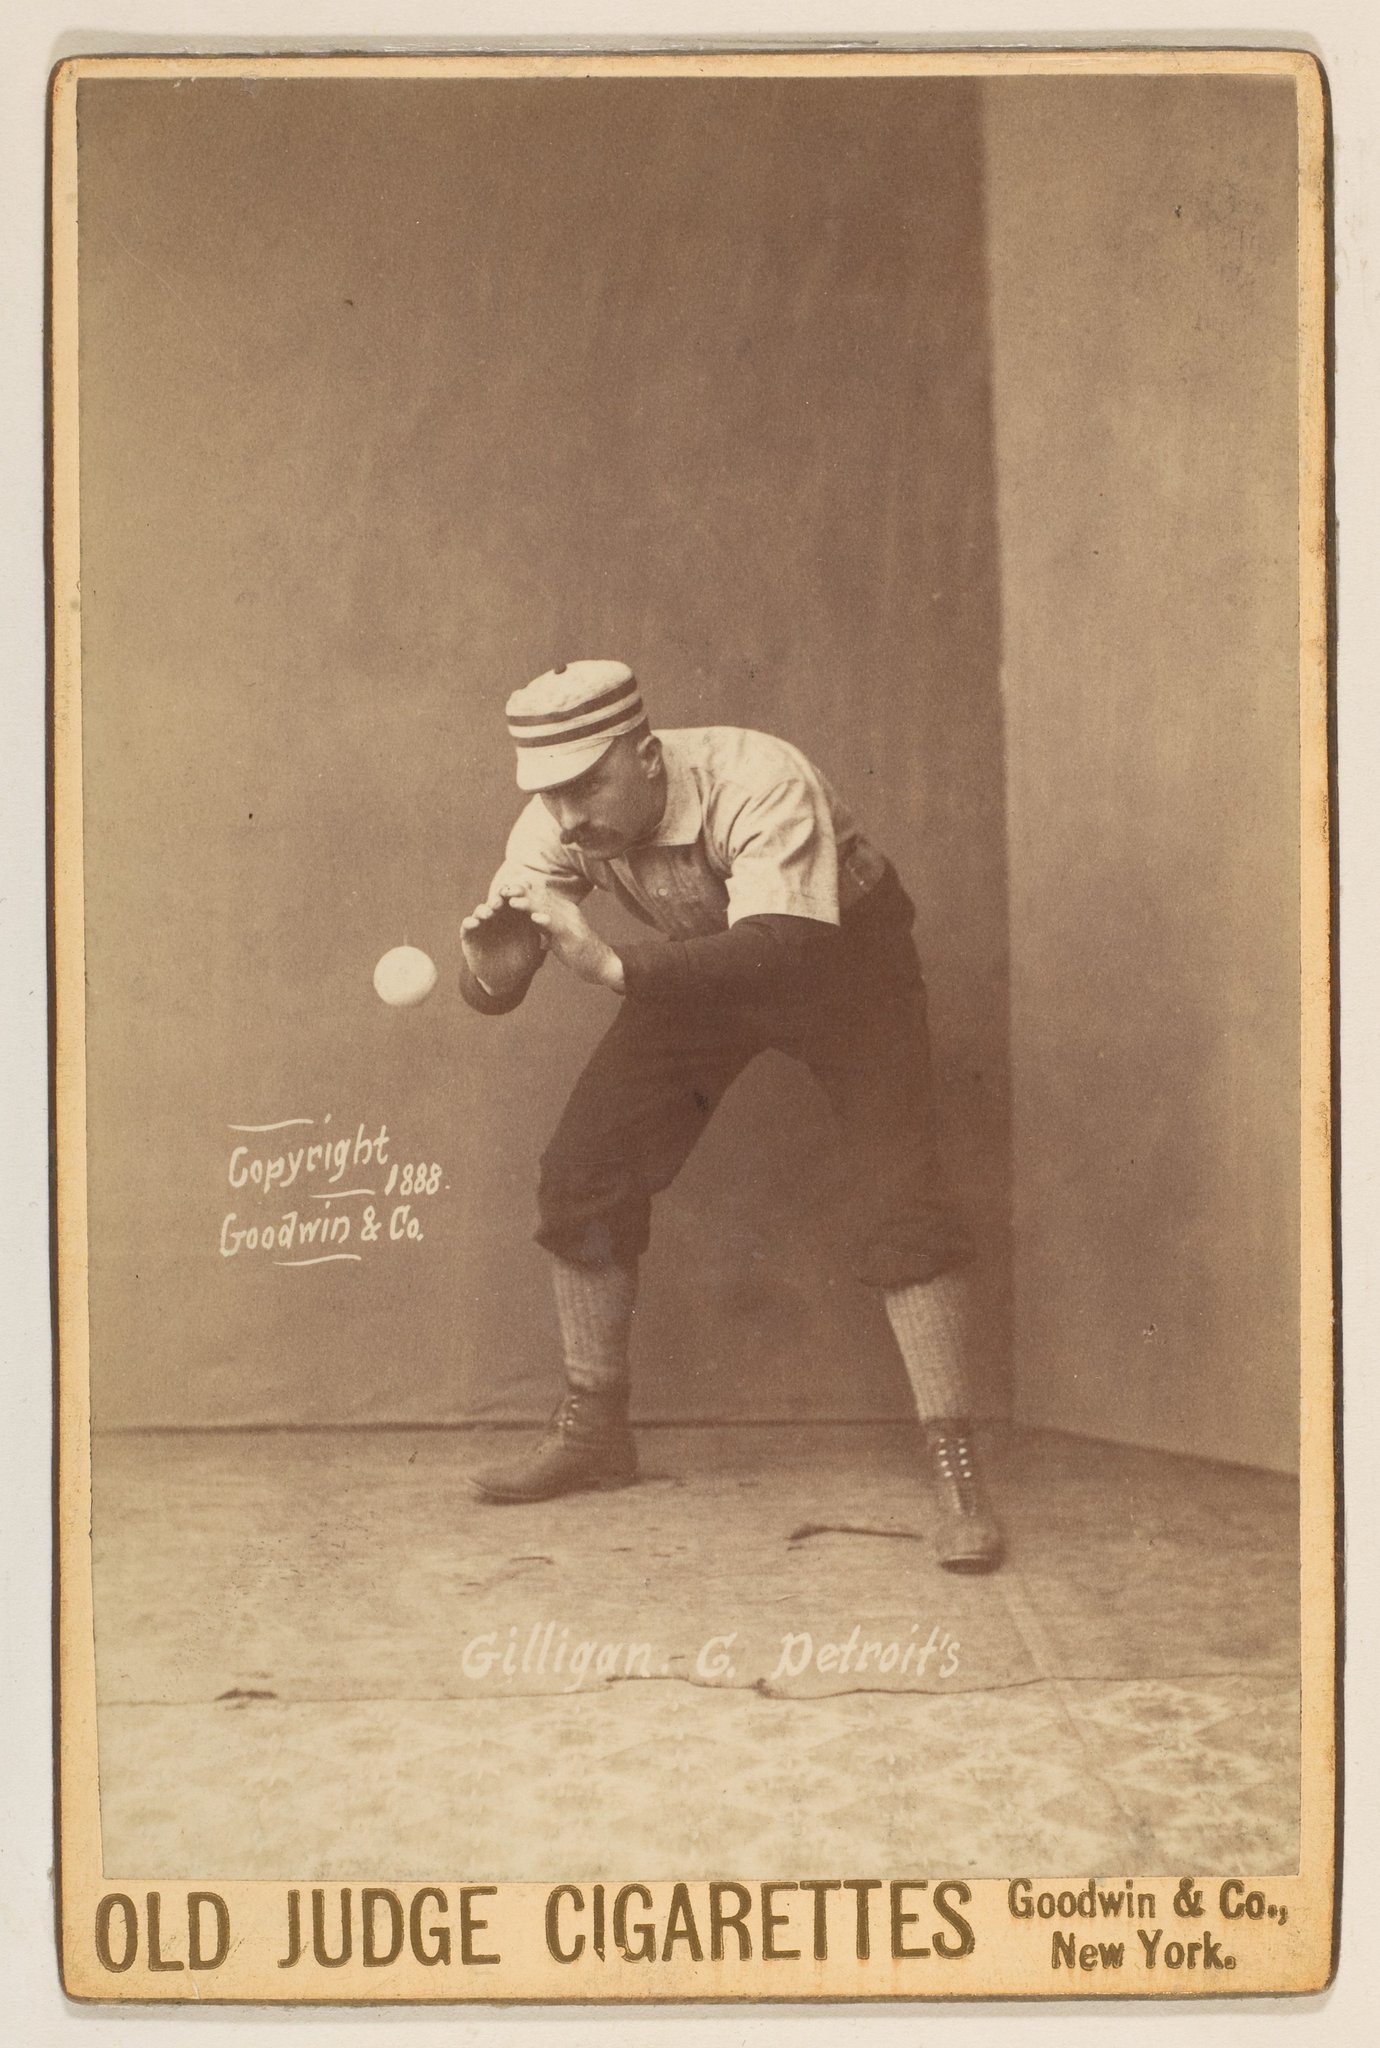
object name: baseball card, photograph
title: Barney Gilligan, Catcher, Detroit, from the series Old Judge Cigarettes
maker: goodwin & company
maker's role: publisher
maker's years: 1850-1950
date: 1888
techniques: albumen print, photography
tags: men,portraits,baseball,athletes